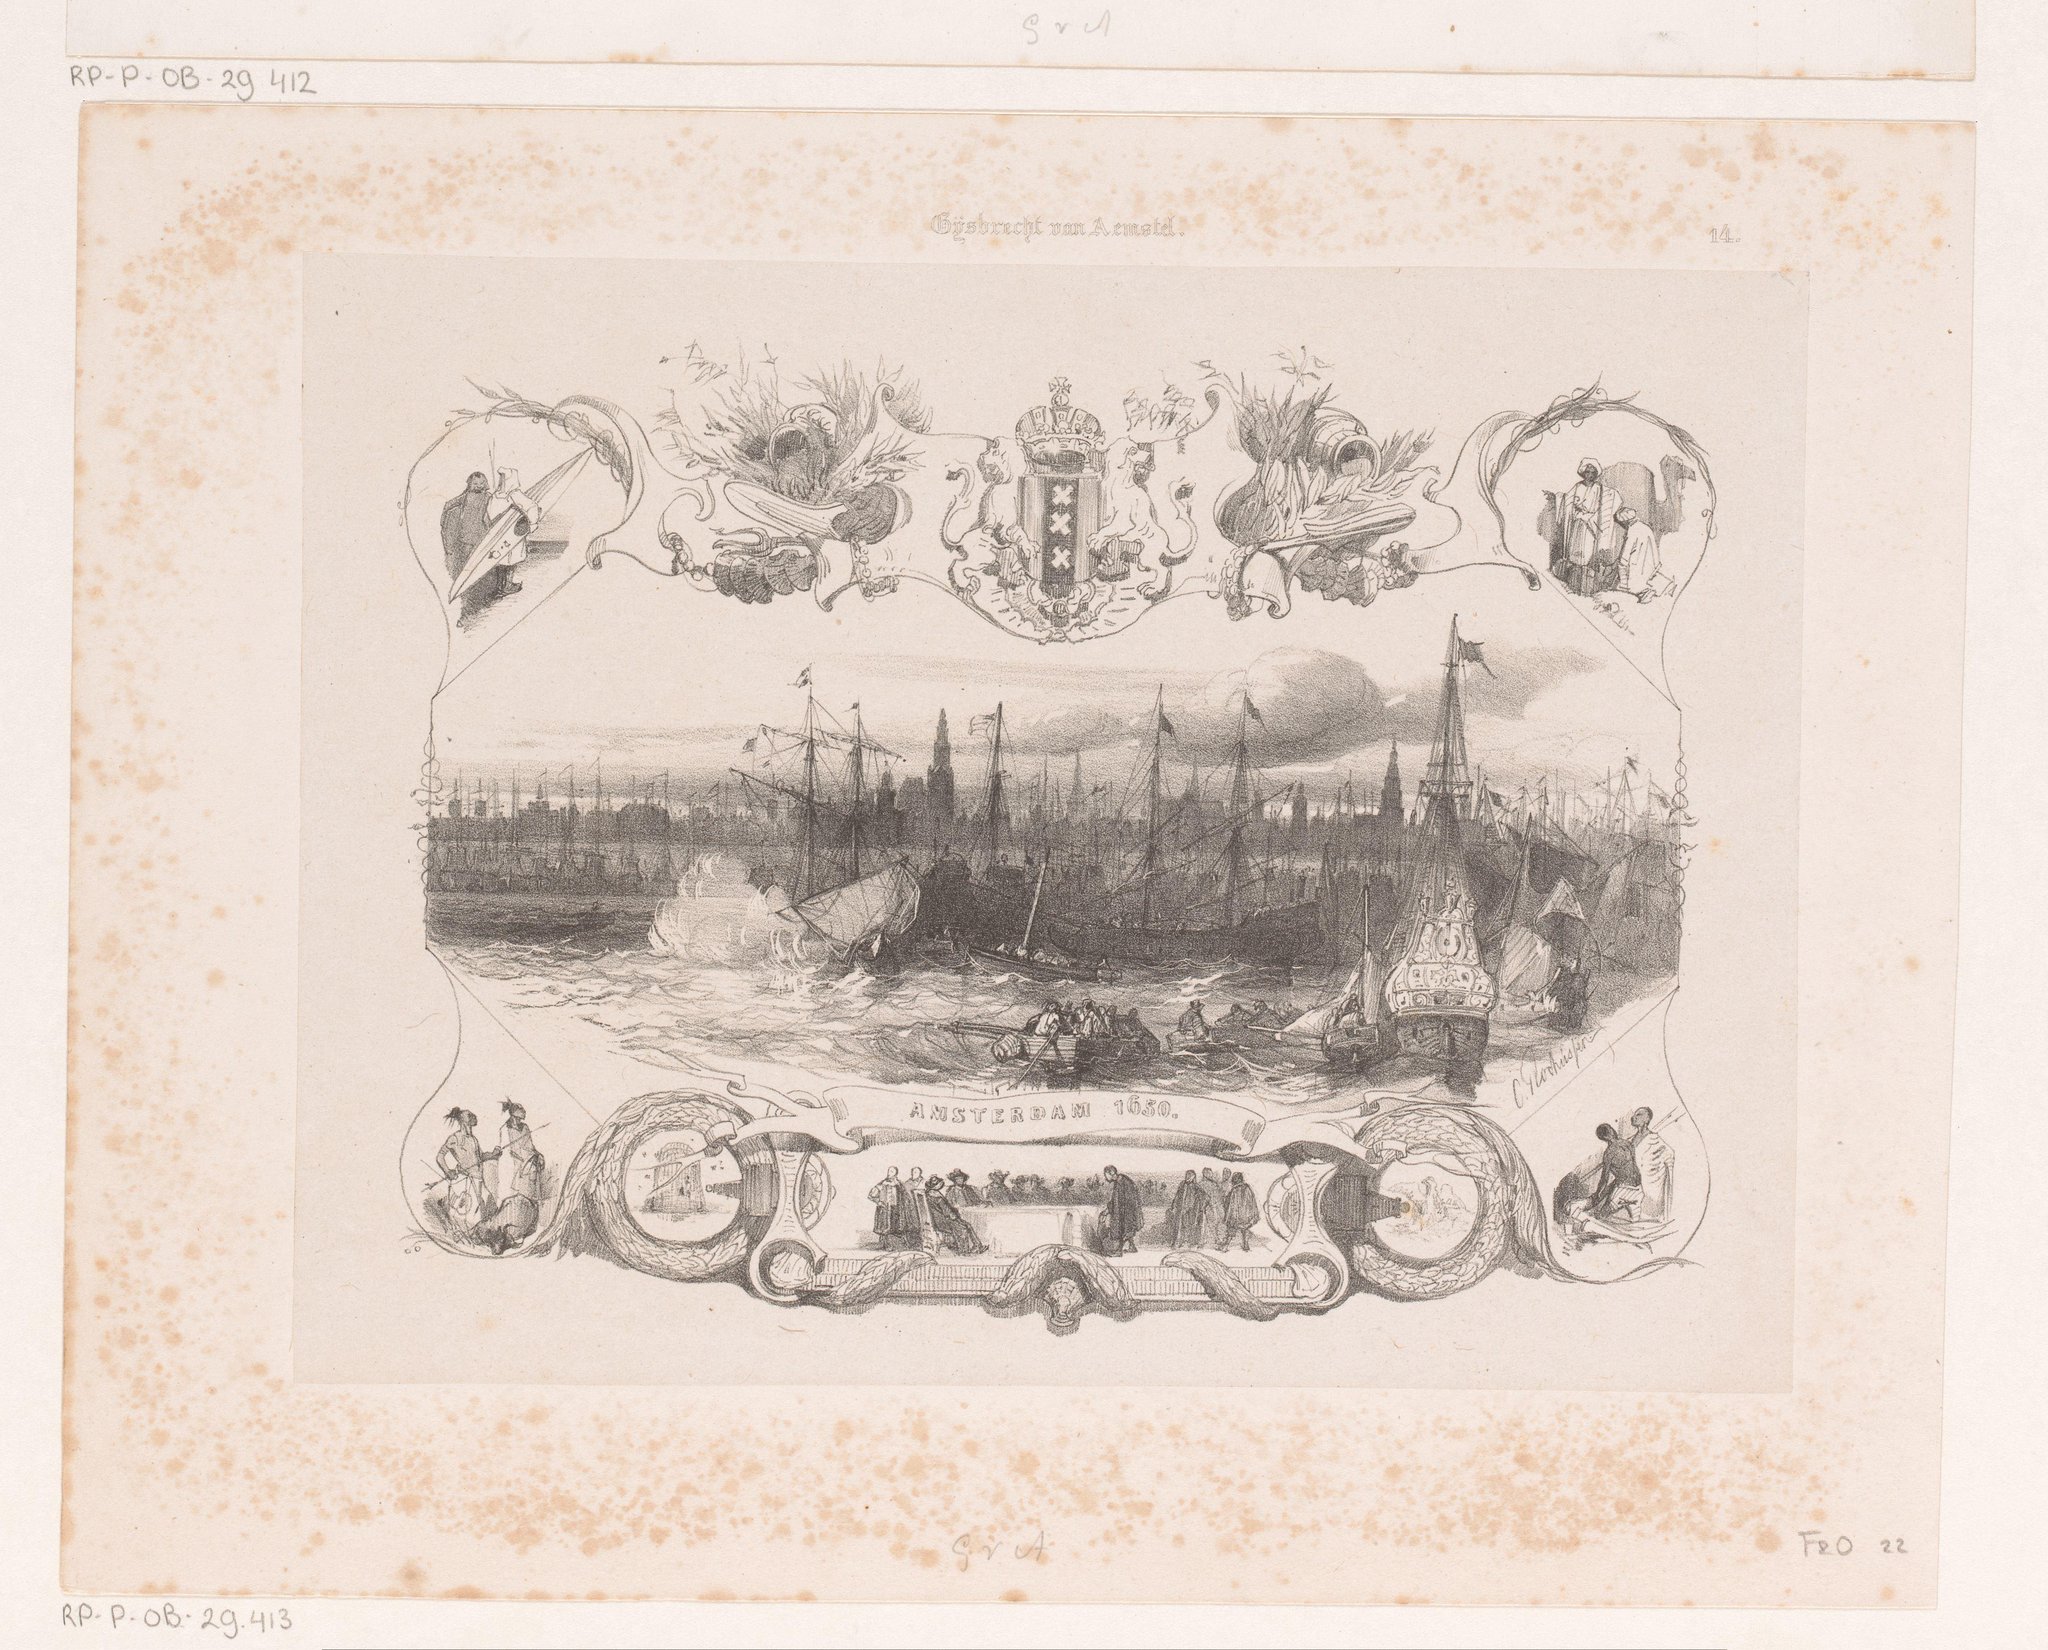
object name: print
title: Schepen op zee voor Amsterdam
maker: charles rochussen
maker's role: draughtsman, painter, print maker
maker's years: 1814-1894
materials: paper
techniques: lithograph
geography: the hague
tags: city-view in general; 'veduta', ships (in general), amsterdam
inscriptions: collector's mark: Lugt 2228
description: Schepen op zee met in de achtergrond een gezicht op Amsterdam. Rondom het wapen van Amsterdam en diverse scènes die duiden op de bloei van de stad in de zeventiende eeuw. In het laatste bedrijf van het treurspel zegt de aartsengel Rafaël Gijsbrecht om Amsterdam te verlaten en dat de stad in latere eeuwen zal herrijzen.